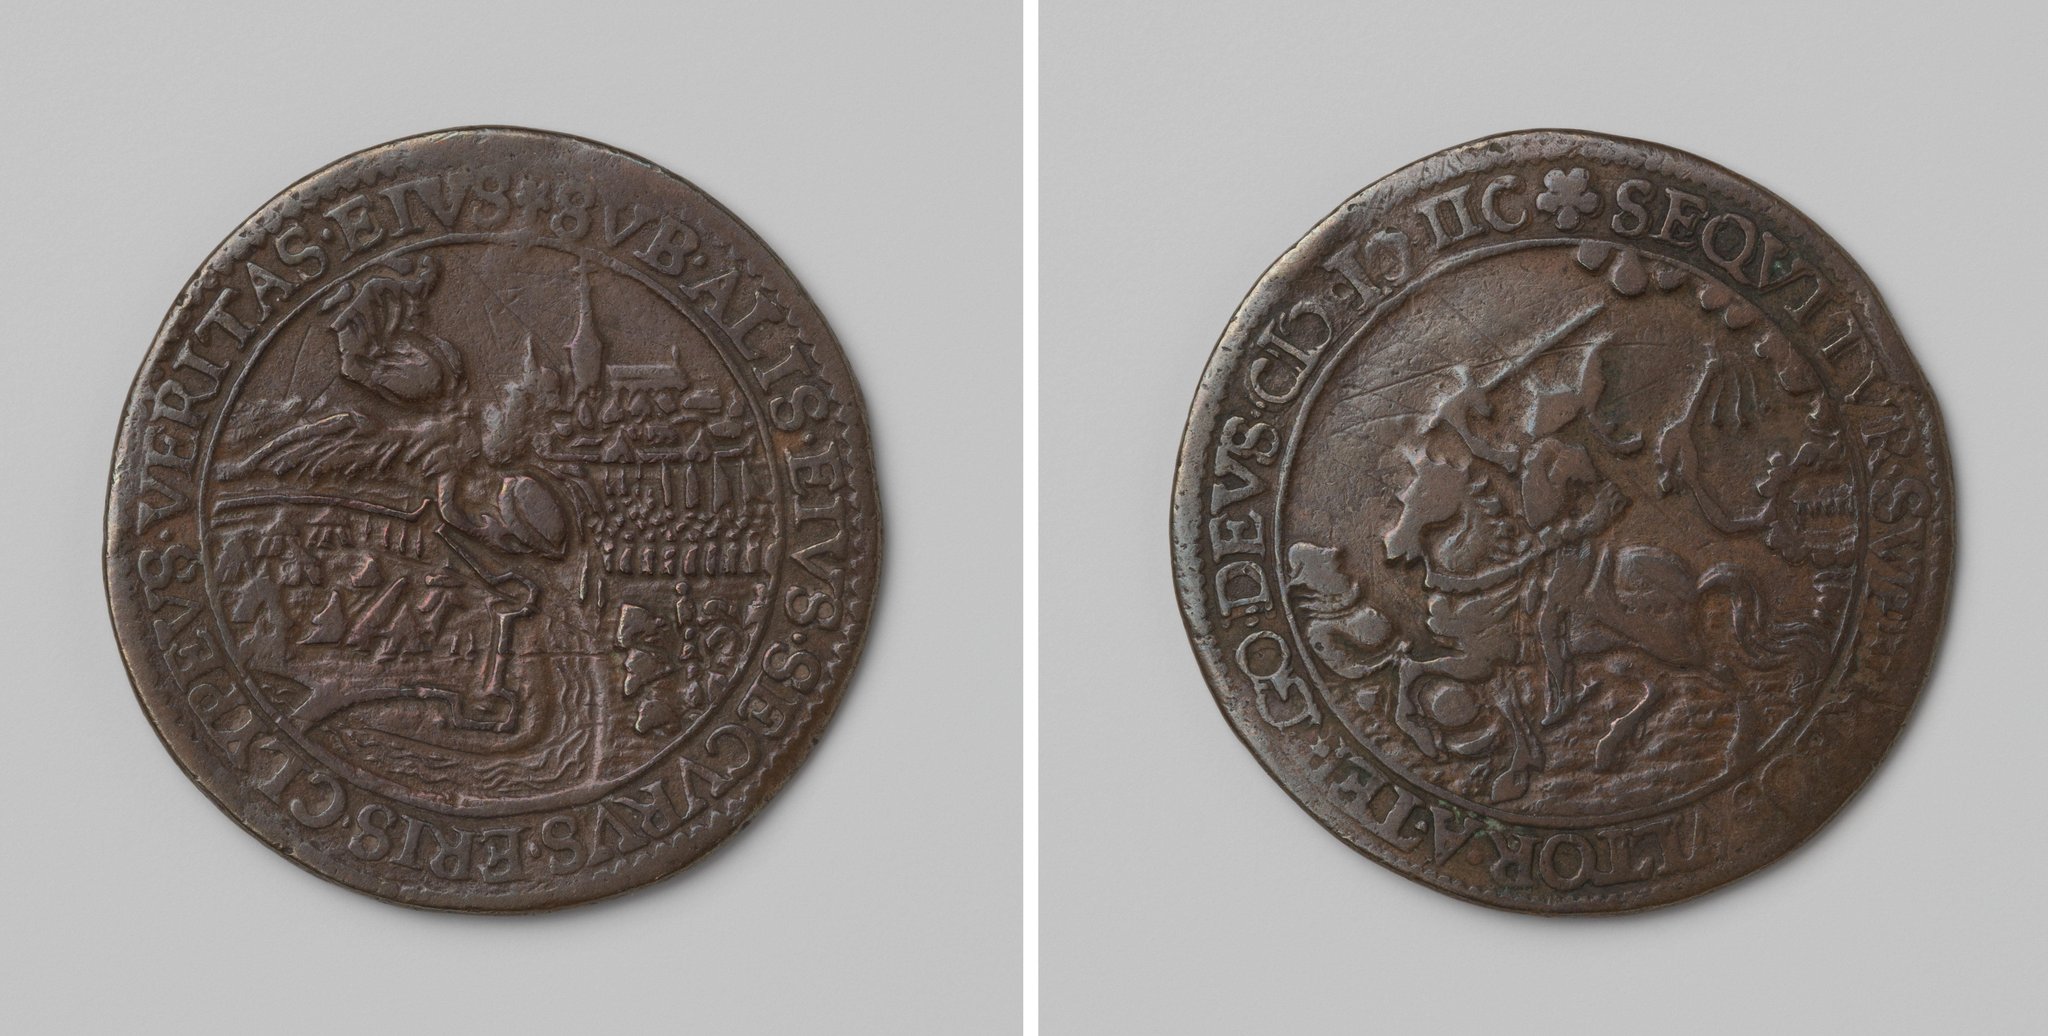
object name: jeton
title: Maurits verhindert dat Mendoza bij Doesburg de IJssel oversteekt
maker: Anonymous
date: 1598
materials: copper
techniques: striking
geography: netherlands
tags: the hague, maurice (prince of orange)